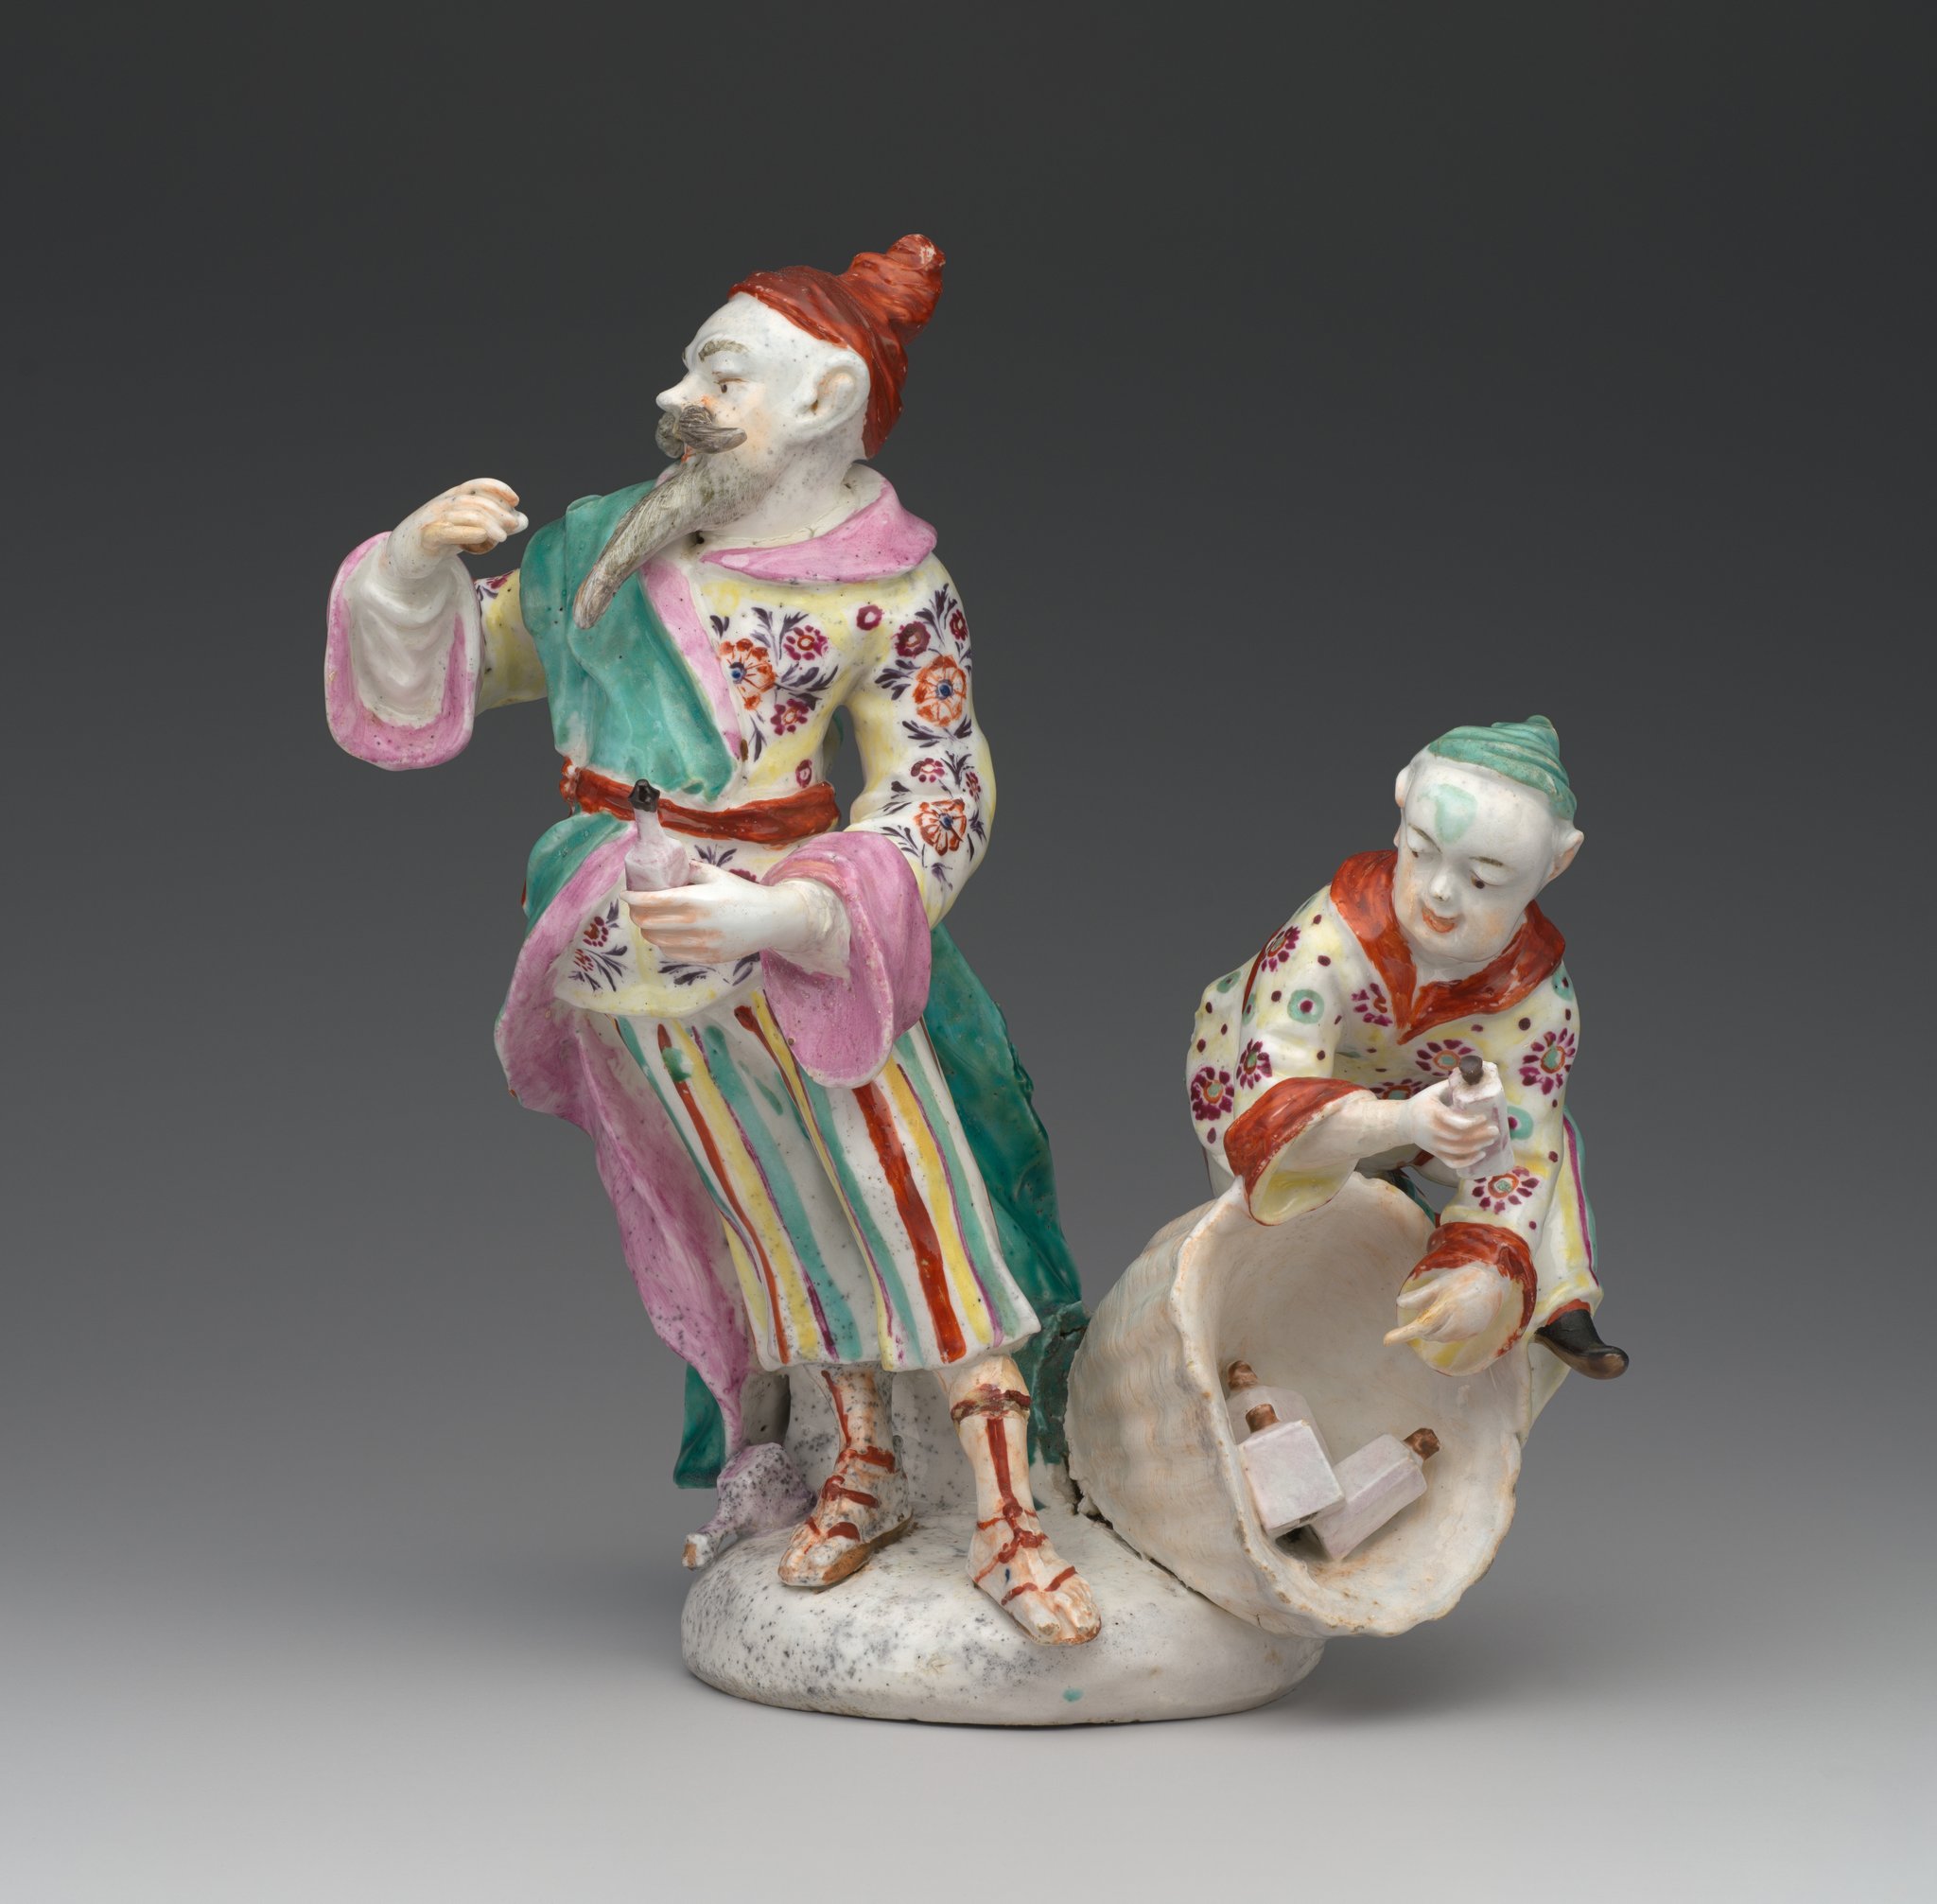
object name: group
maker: derby porcelain manufactory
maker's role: factory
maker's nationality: british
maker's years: 1751-1785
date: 1755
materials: soft paste porcelain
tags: boys,men